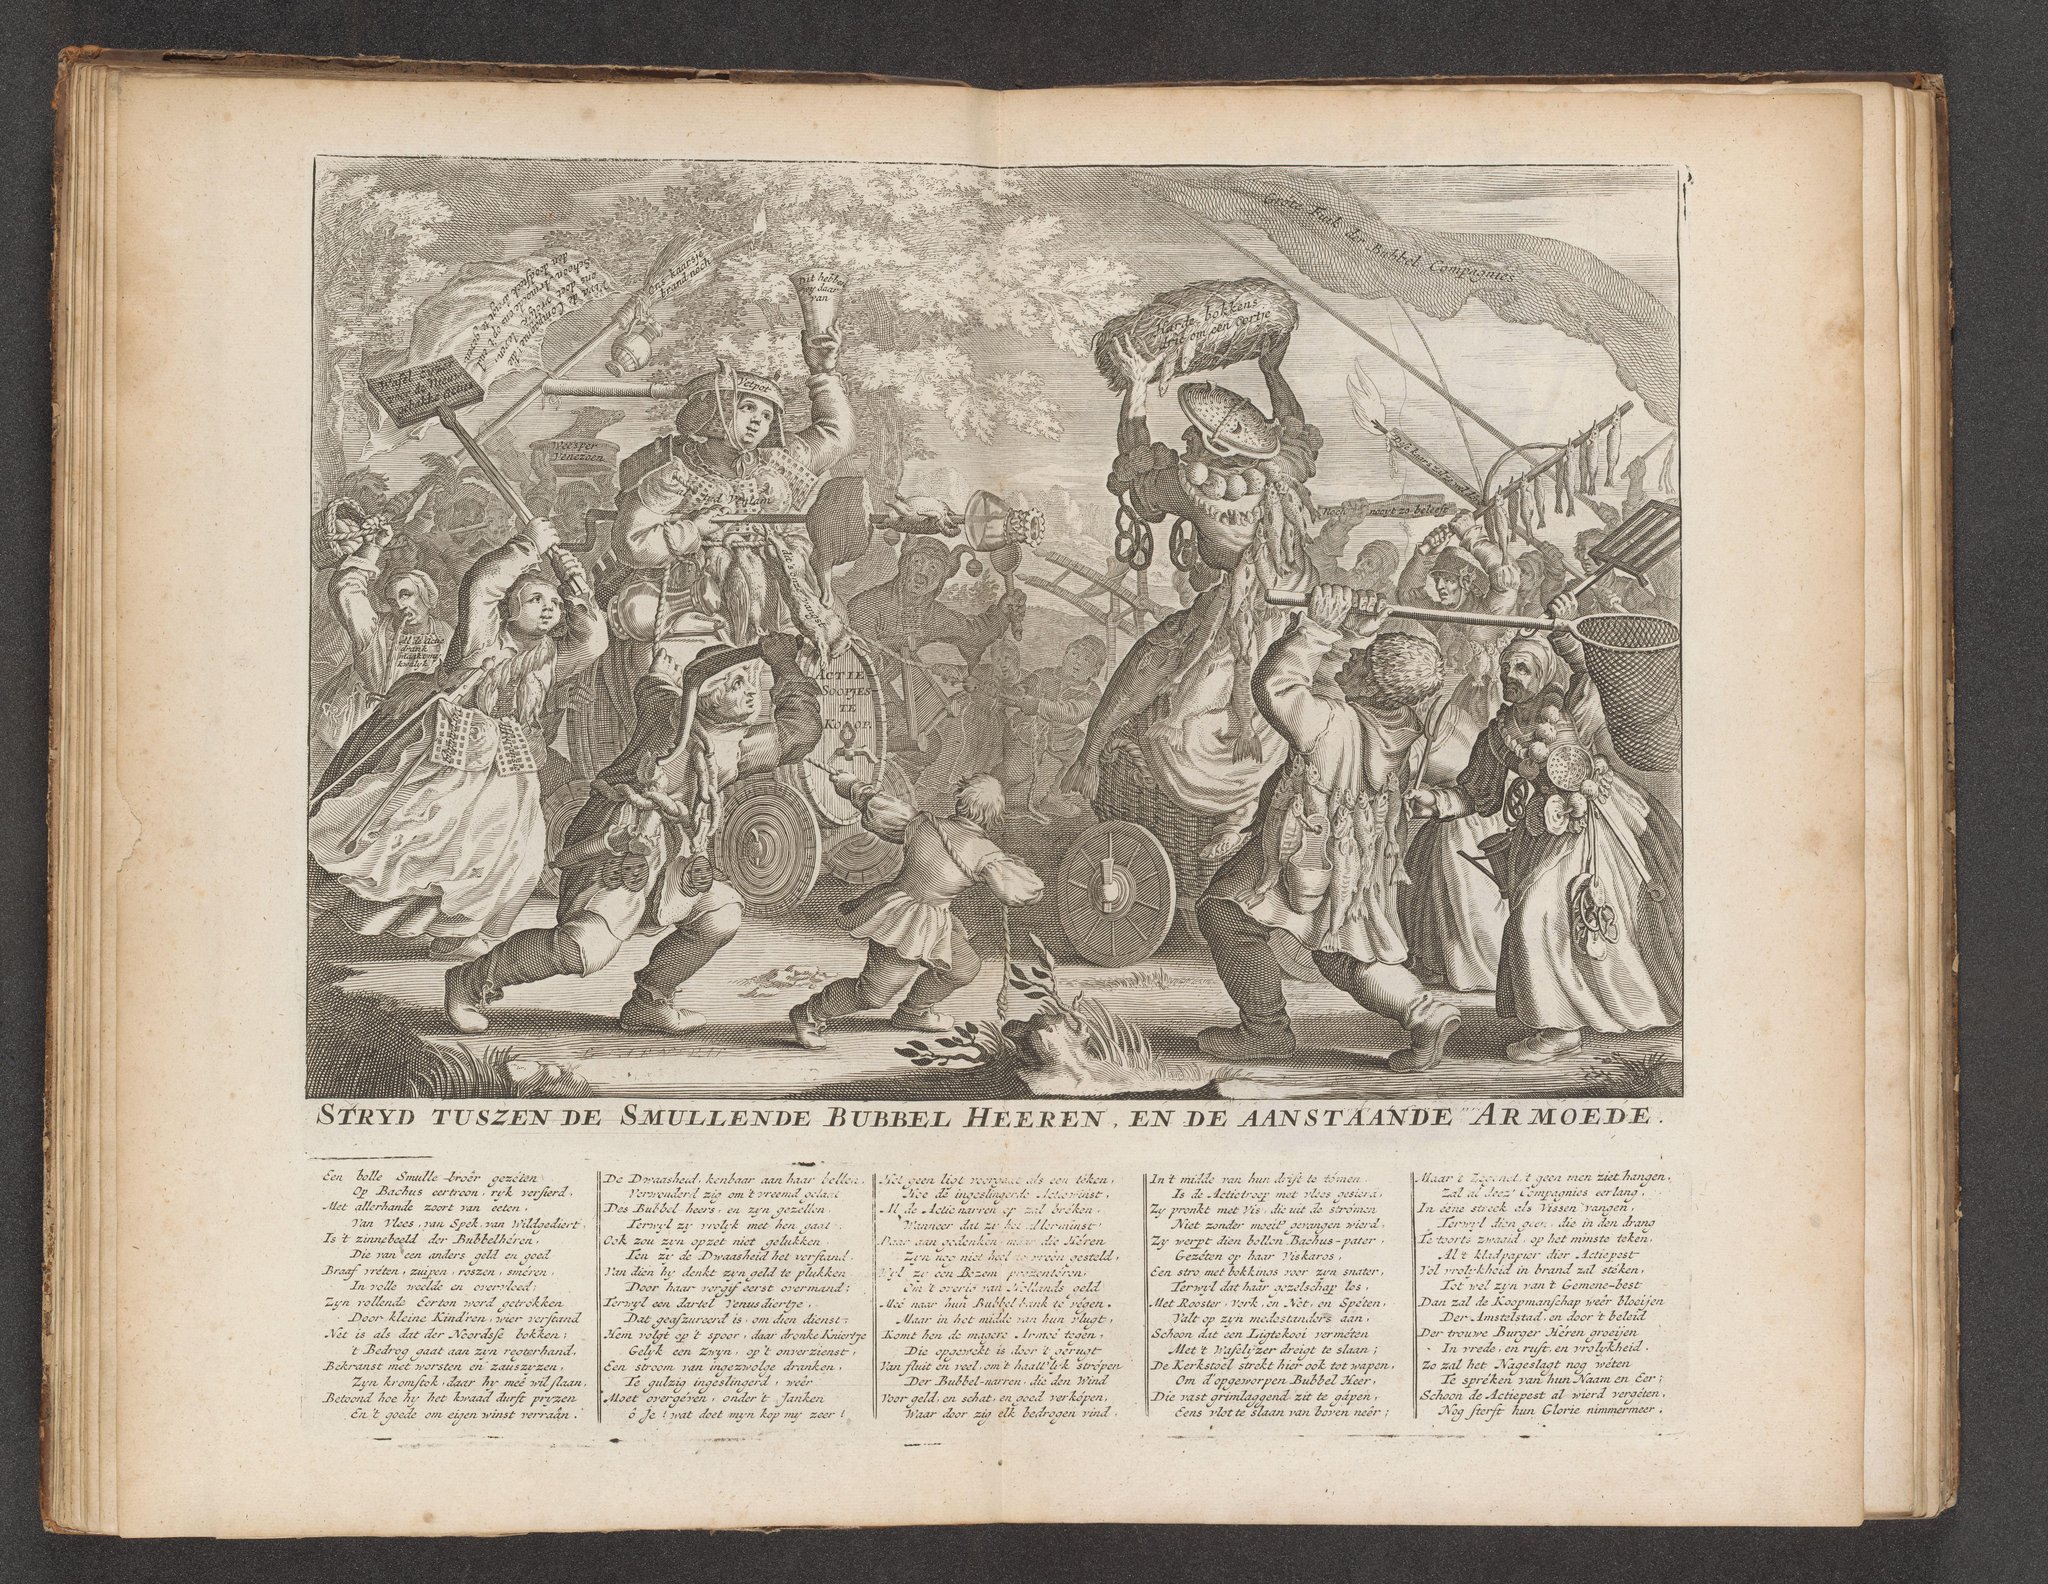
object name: print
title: Strijd tussen de windhandel en de aanstaande armoede, 1720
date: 1600-1633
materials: paper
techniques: engraving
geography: northern netherlands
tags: strife of lent and carnival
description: Spotprent met de strijd tussen Vastenavond en Vasten geplaatst in de context van de Windhandel van 1720. Strijd tussen twee personen op strijdwagens getrokken door kinderen. Links Vastenavond, aangekleed met keukeninstrumenten, wild en gevogelte, drinkglazen en kannen. Zij en haar aanhangers dragen verwijzingen naar de actiehandel. Rechts Vasten, aangekleed met vissen en krakelingen, verwijst naar de aanstaande armoede. In het onderschrift een vers in vijf kolommen, gedrukt van een aparte plaat. Prent in de gebonden vierde uitgave (304 B 12) van Het Groote Tafereel der Dwaasheid met spotprenten op de Windhandel of Actiehandel van 1720.